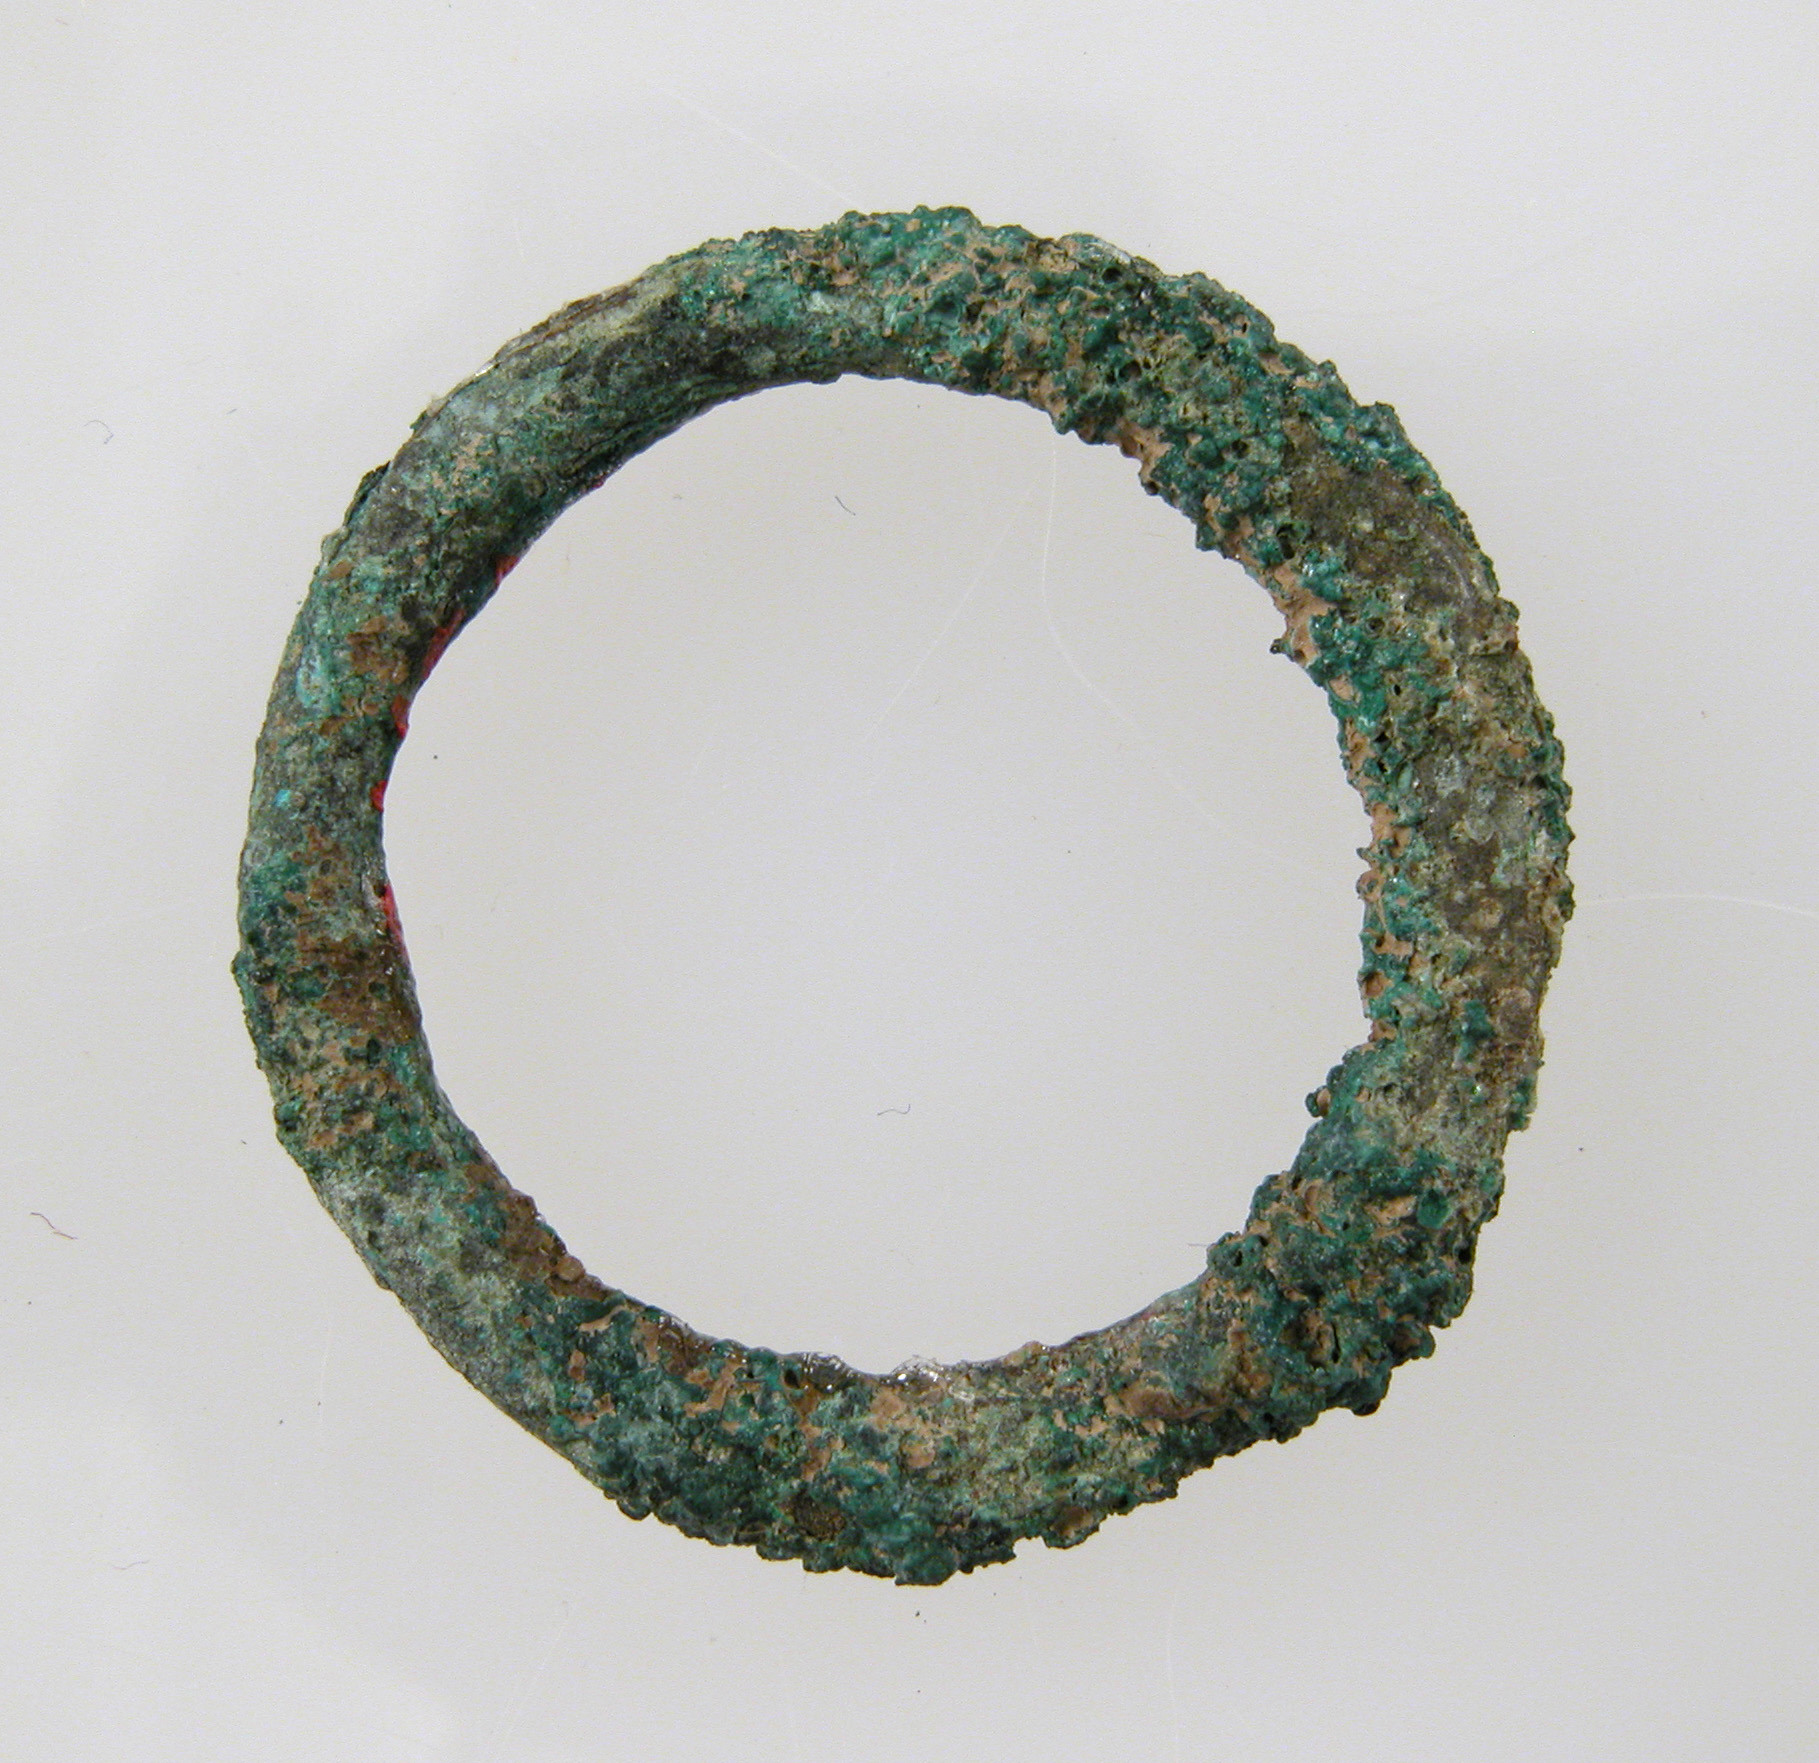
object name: ring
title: Plain Ring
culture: frankish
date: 601-700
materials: copper alloy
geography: germany